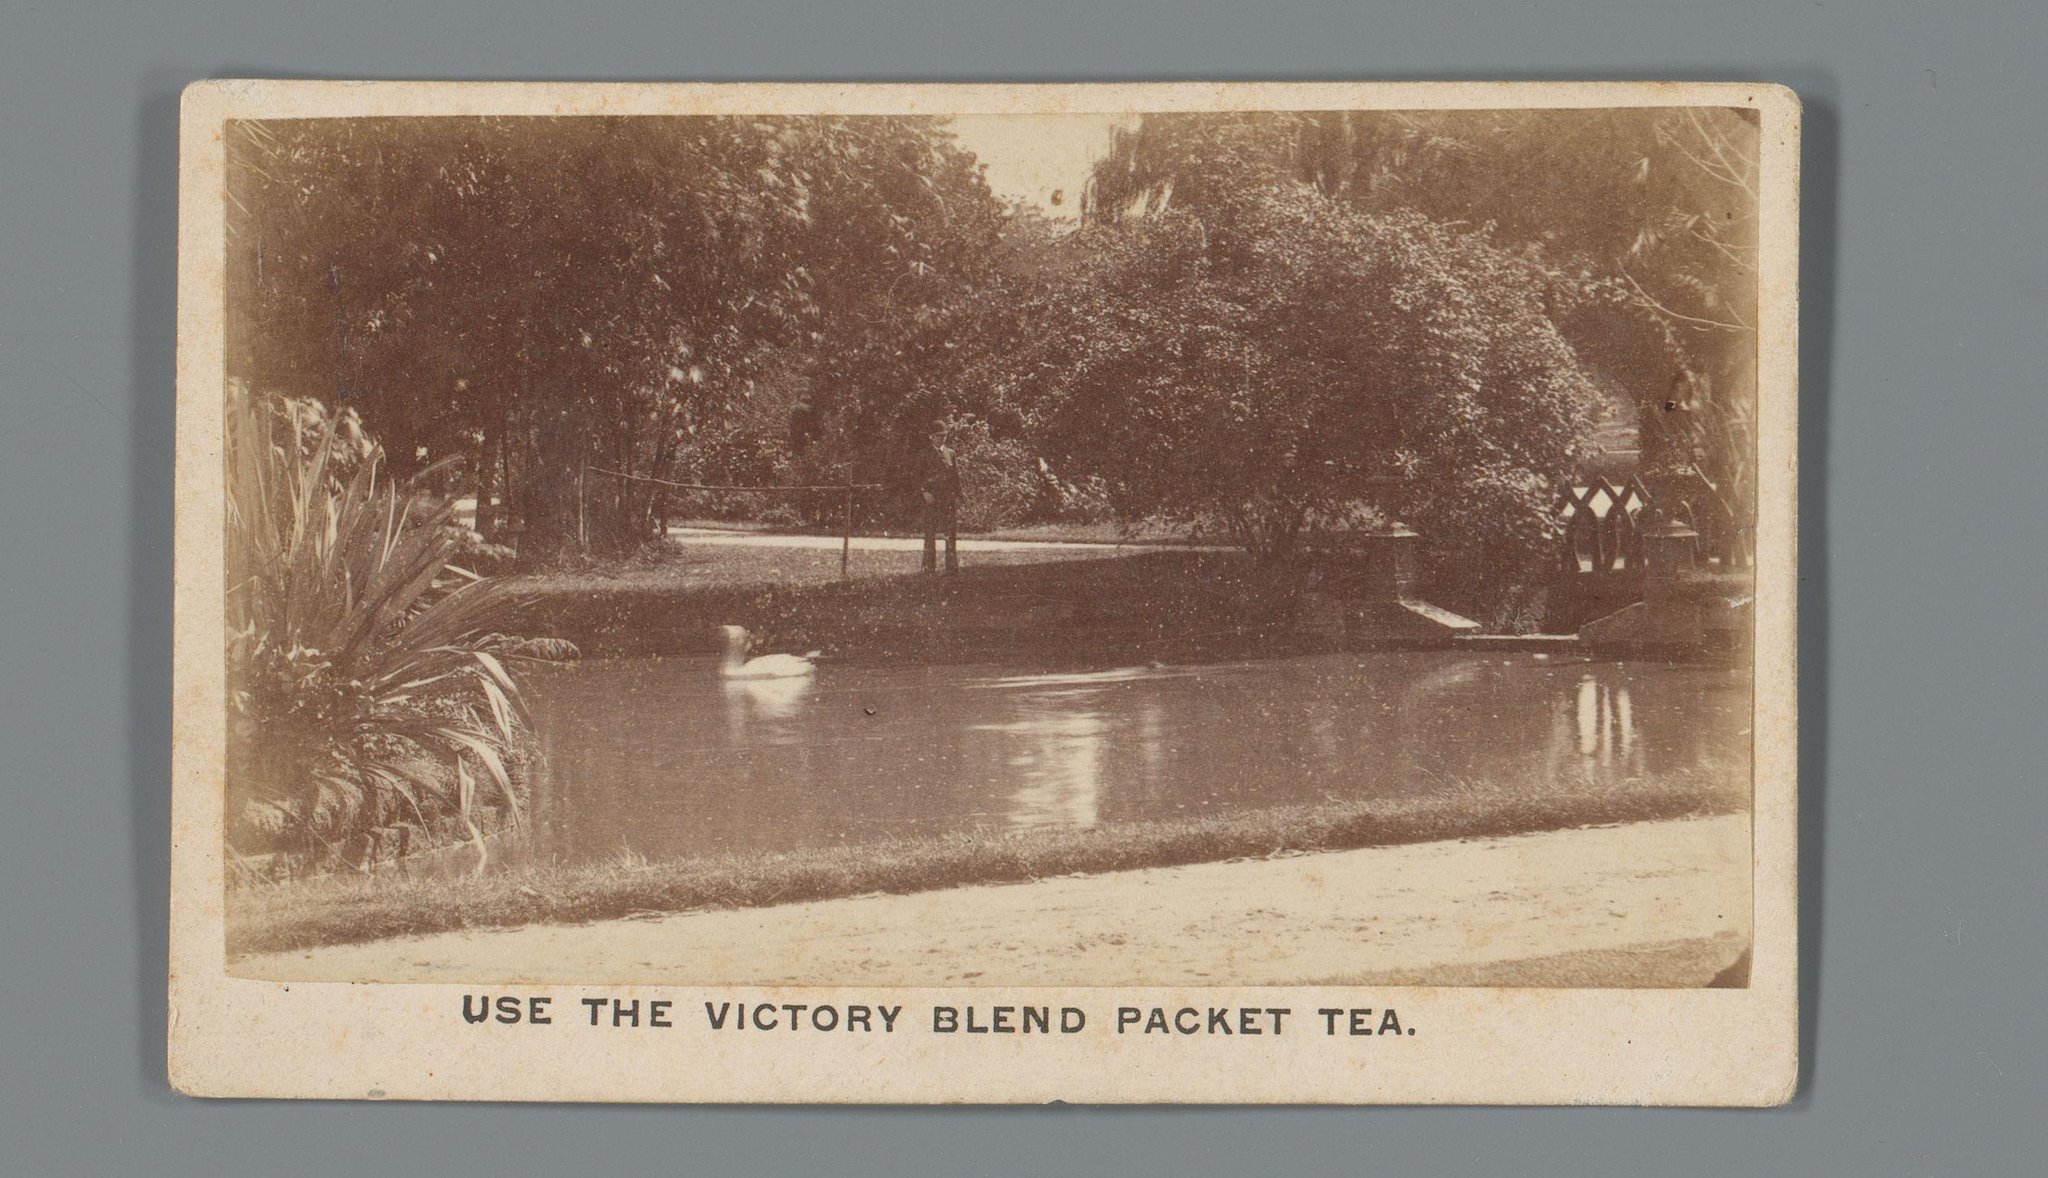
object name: photograph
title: Gezicht op een botanische tuin met water in Sydney als reclame voor thee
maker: Anonymous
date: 1850-1915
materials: cardboard, photographic support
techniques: albumen print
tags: advertising, water-birds: swan, water course, tea (leaves), botanic garden, 'hortus botanicus'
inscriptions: inscription: ‘View in the Botanical Gardens,/ SYDNEY.’, inscription: ‘USE THE VICTORY BLEND TEA.’